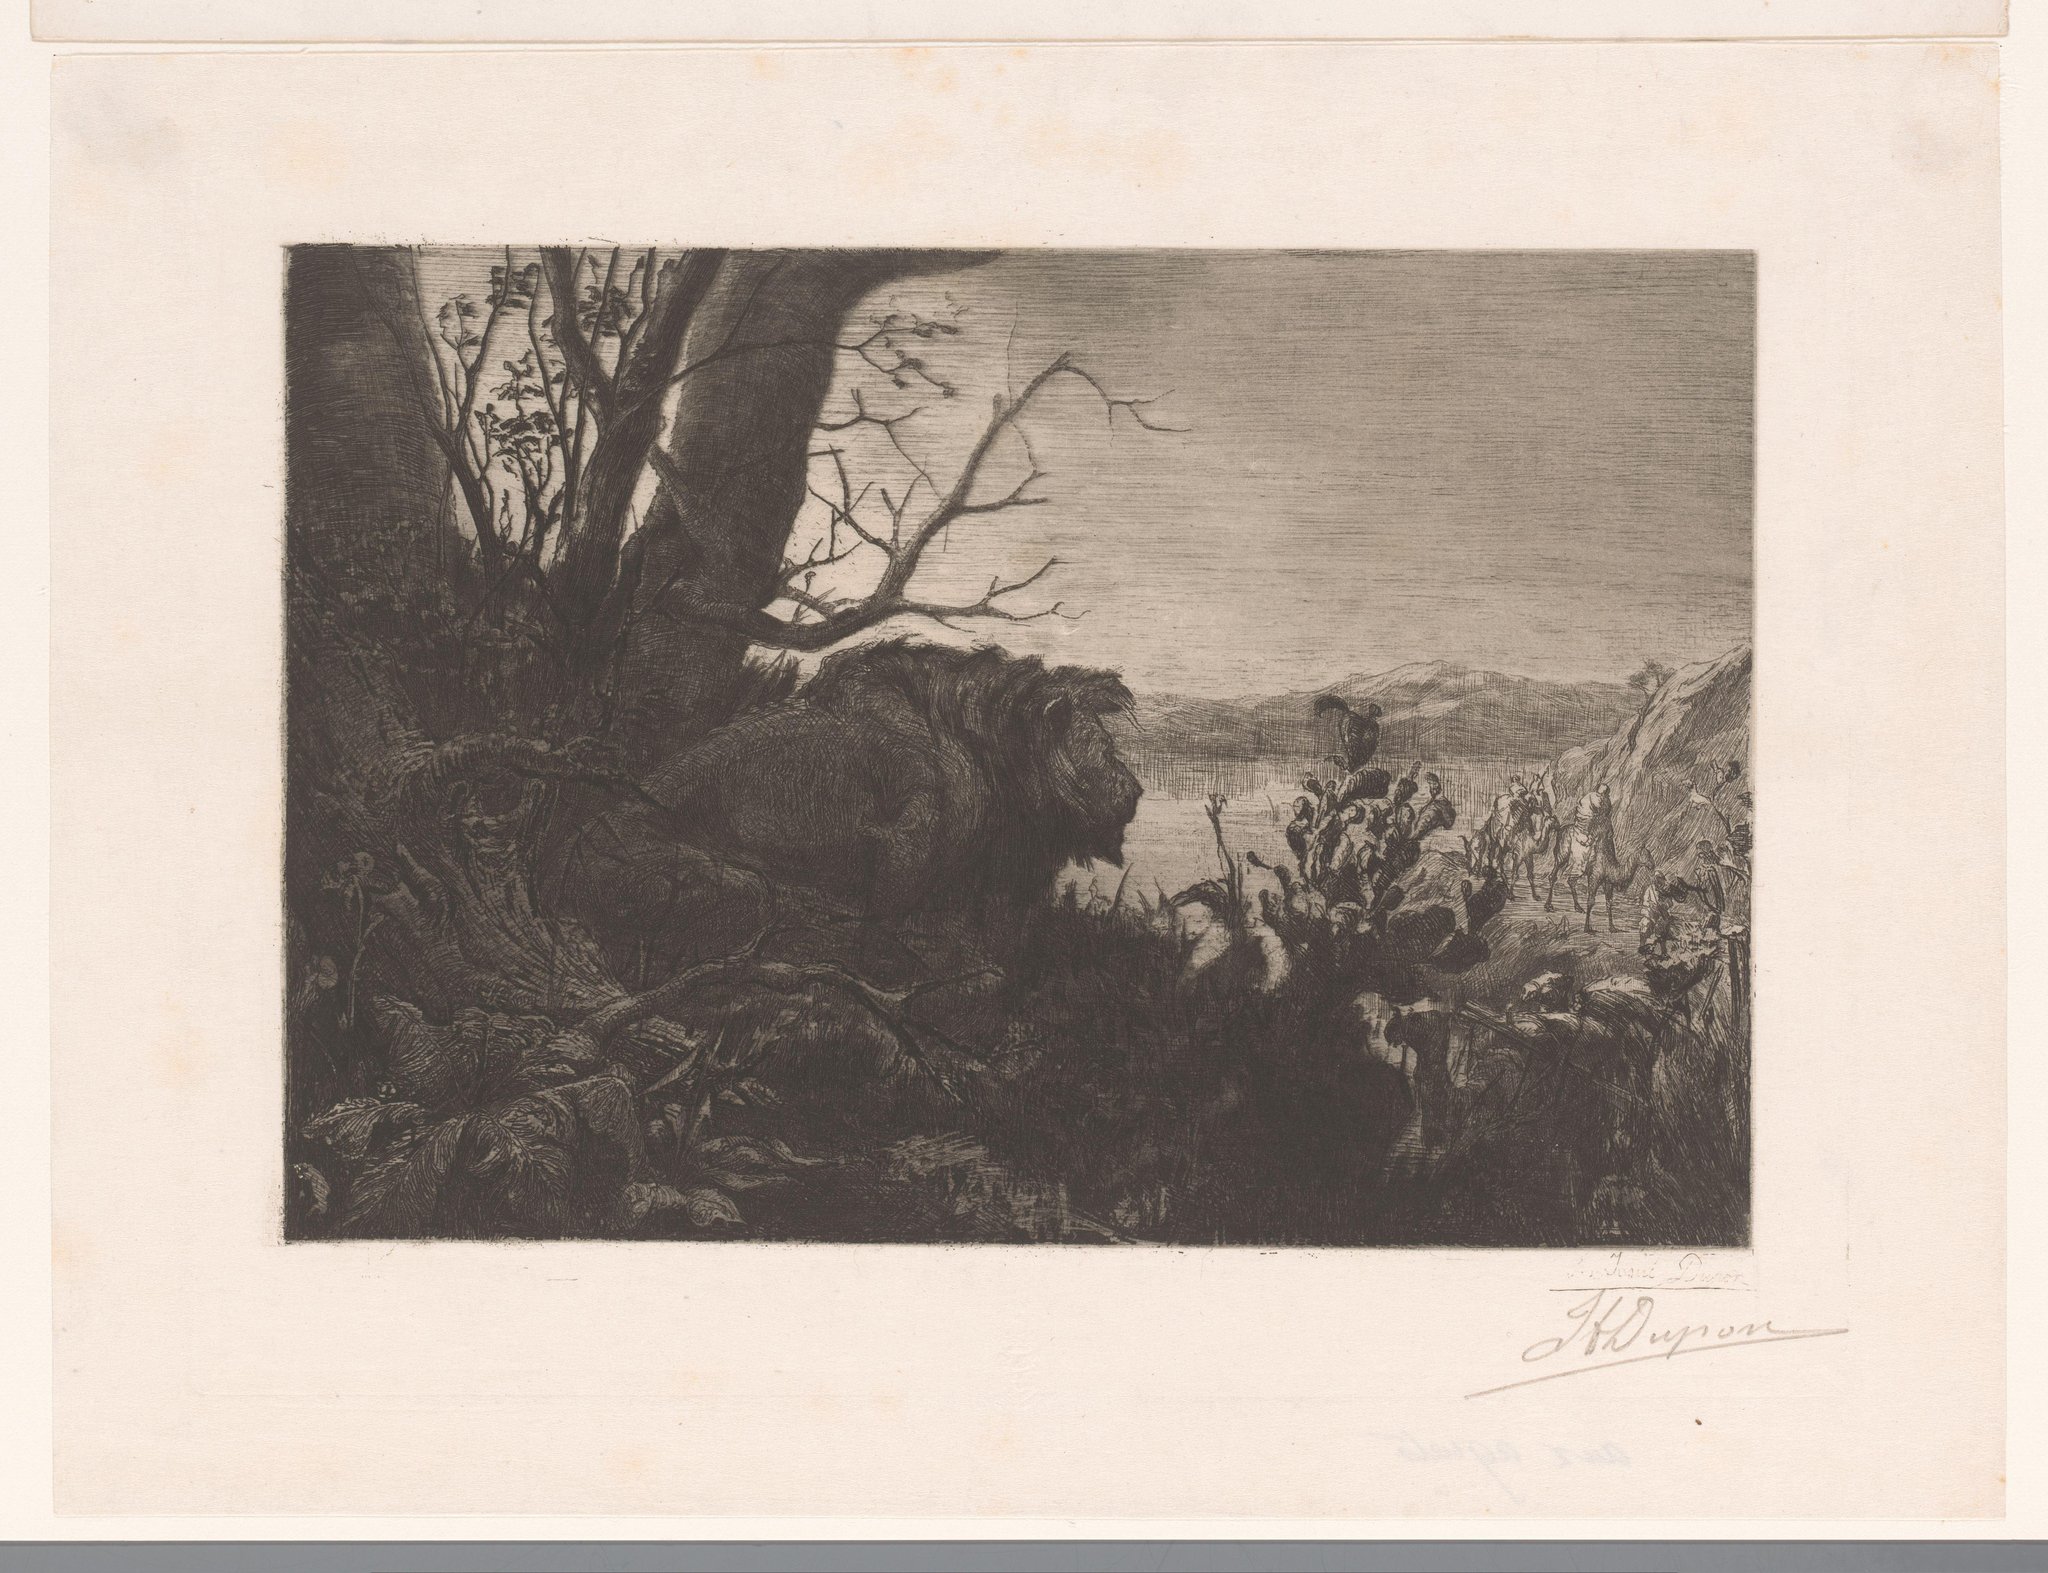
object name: print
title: Leeuw op de loer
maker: josué dupon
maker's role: print maker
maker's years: 1864-1935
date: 1874-1909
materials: paper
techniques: drypoint, etching, intaglio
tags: hoofed animals: dromedary, landscapes (+ landscape with figures, staffage), beasts of prey, predatory animals: lion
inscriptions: collector's mark: Lugt 2228, mark: ‘Antwerpsche Etsers 1880.’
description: Landschap met een leeuw die naar een voorbijkomende karavaan loert.